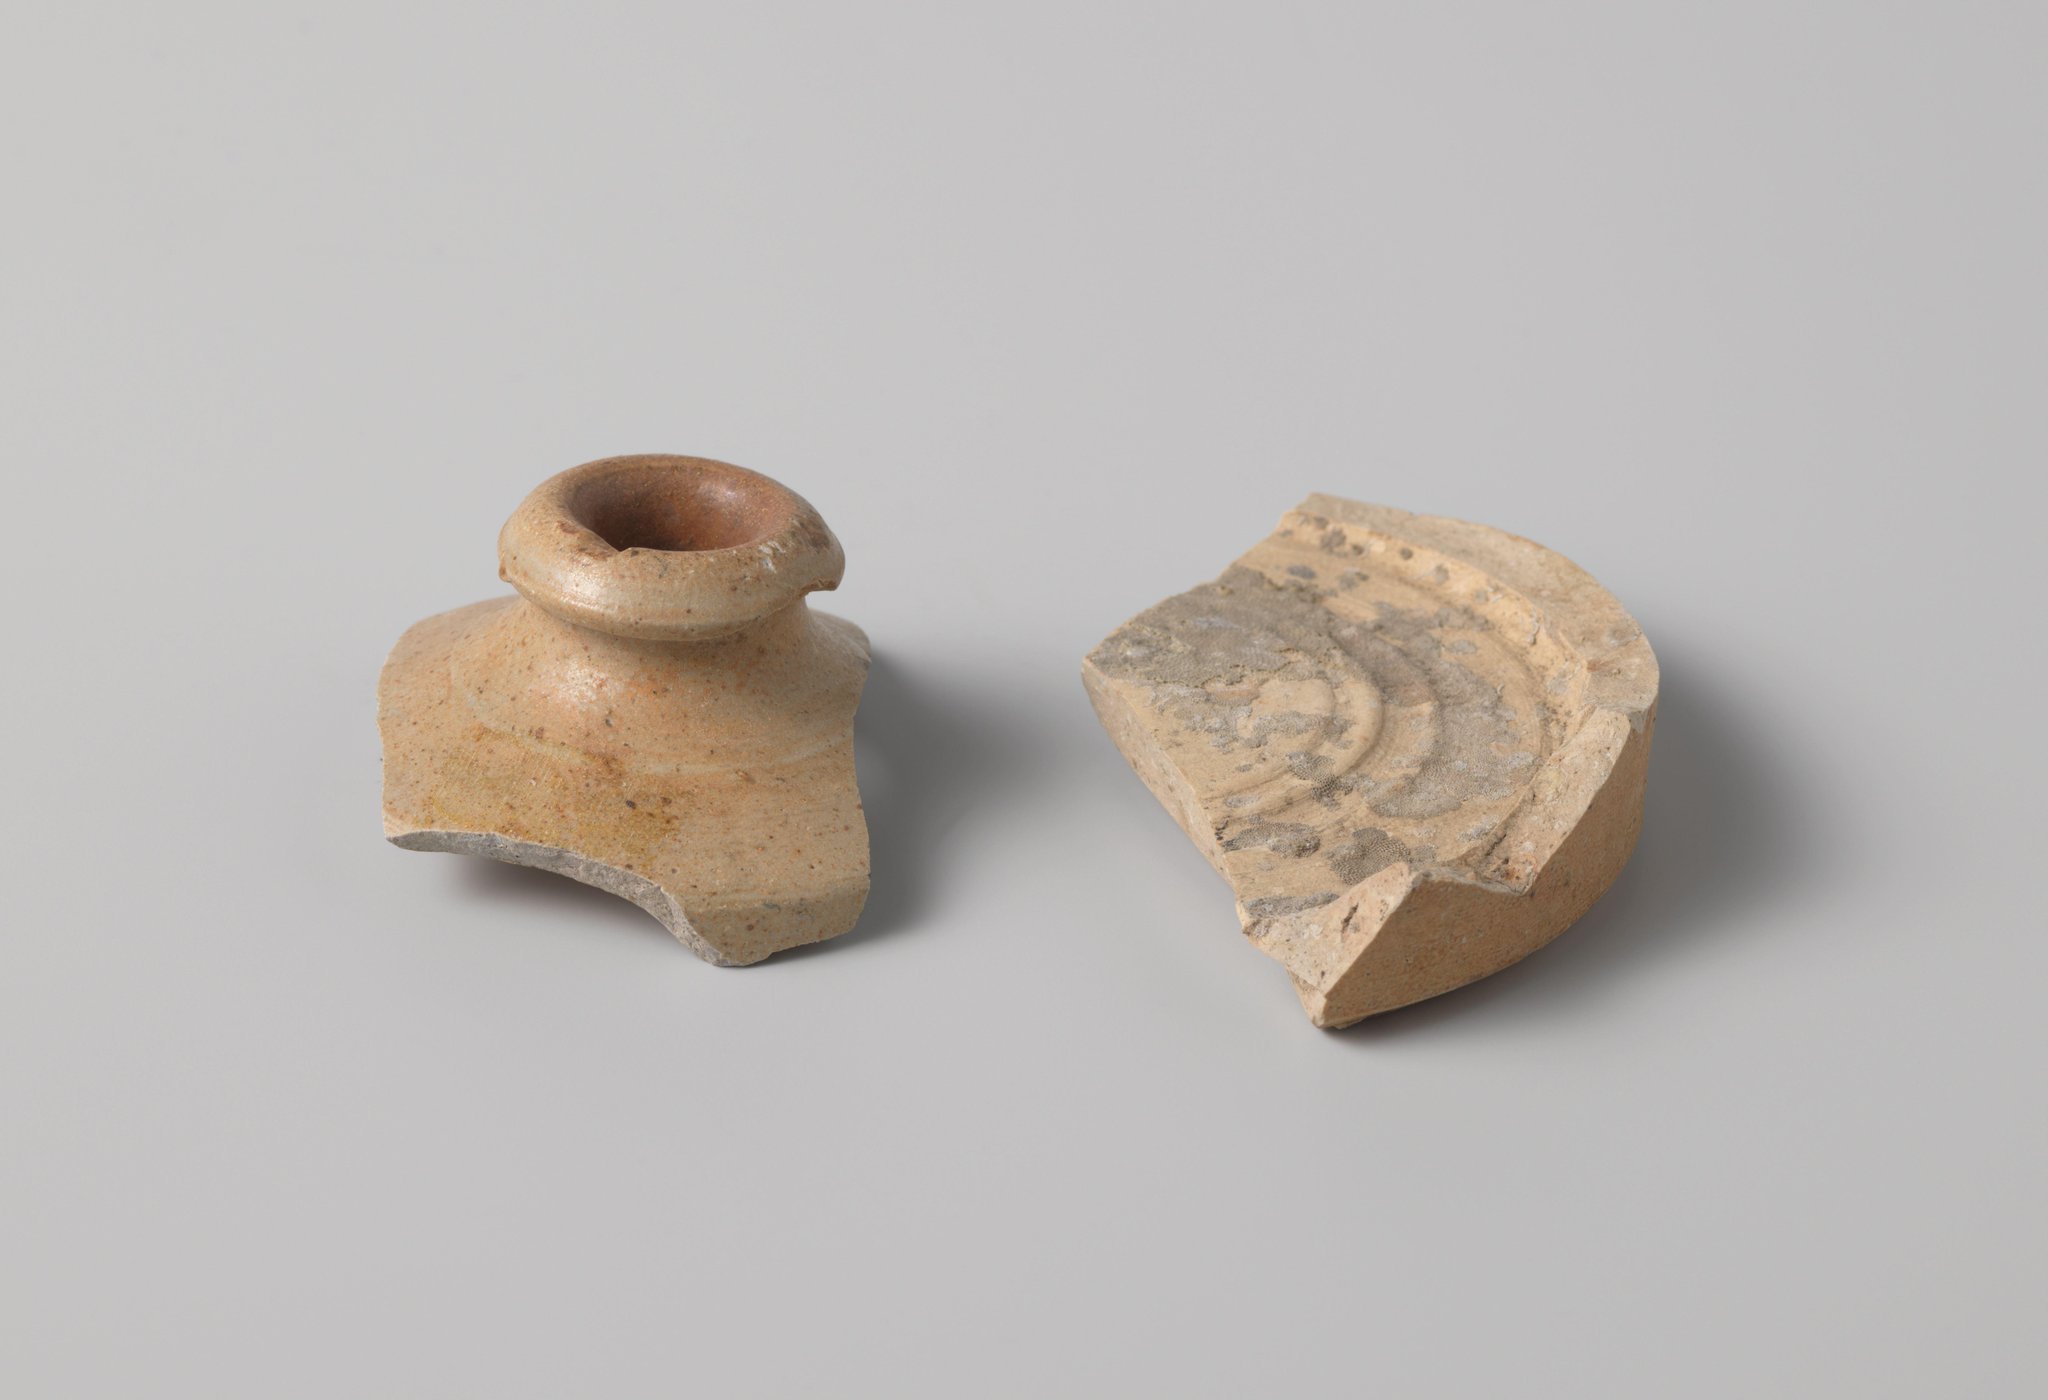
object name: sherd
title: Twee steengoedscherven, gevonden bij V.O.C.-schip Witte Leeuw, mogelijk afkomstig van Zeelelie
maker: Anonymous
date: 1750-1799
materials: stoneware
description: Bodemfragment en halsfragment van steengoed, gevonden bij V.O.C.-schip de 'Witte Leeuw'. Dit object is 18e-eeuws en kan dus niet van de vracht van de Witte Leeuw zijn. Onduidelijk is of het object van de site komt of dat het later is vermengd, mogelijk met materiaal van de Zeelelie.